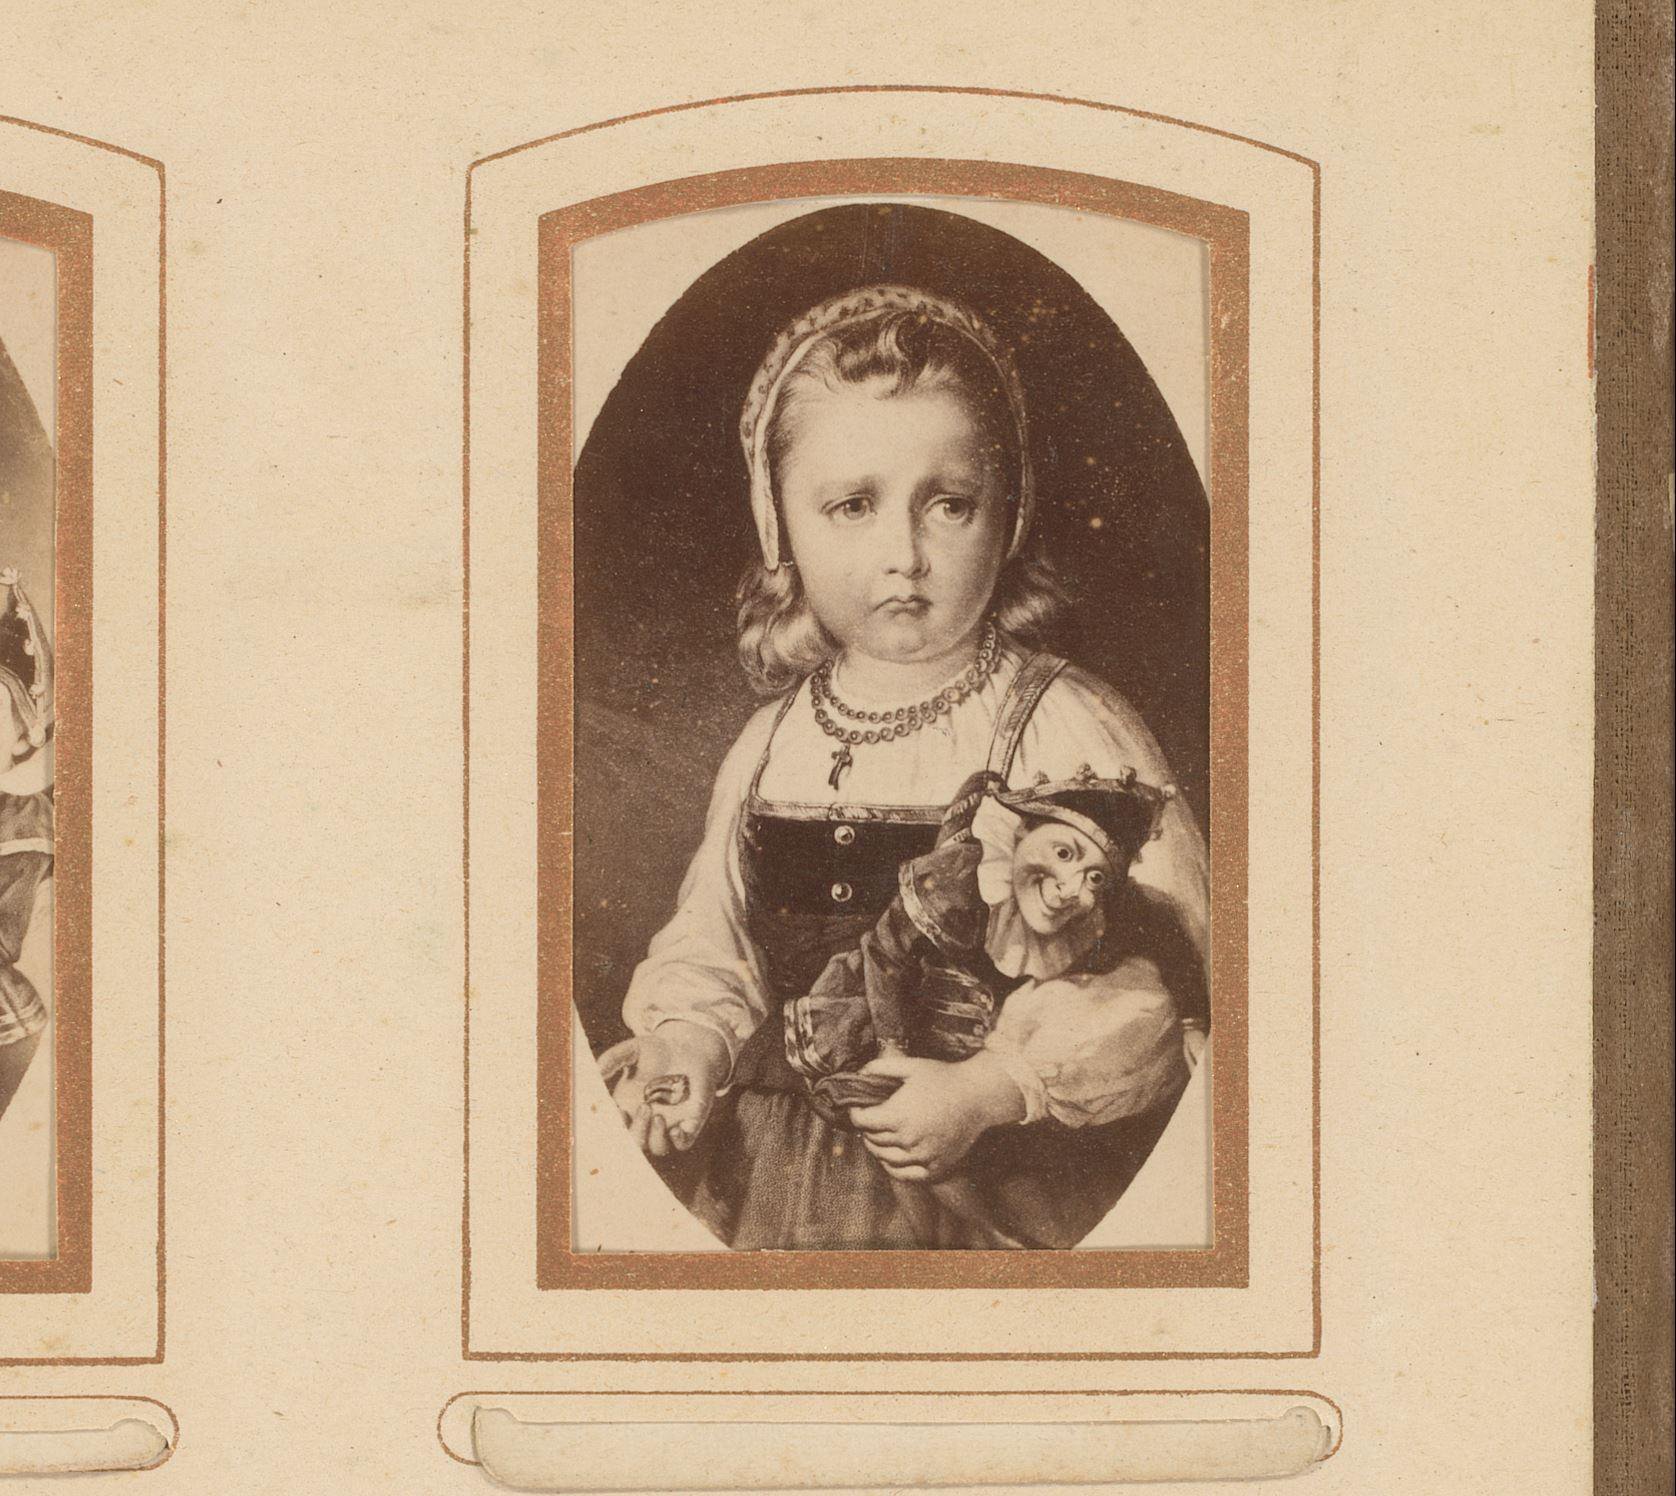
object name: album leaf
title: Fotoreproductie van een geschilderd portret van een verdrietig kijkend meisje met een pop op de arm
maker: Anonymous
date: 1850-1900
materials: cardboard, photographic support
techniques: albumen print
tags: historical persons - bb - woman, pain, sorrow, sadness; 'dolore', 'dolore di zeusi' (ripa), (playing with) dolls, toddler (female)